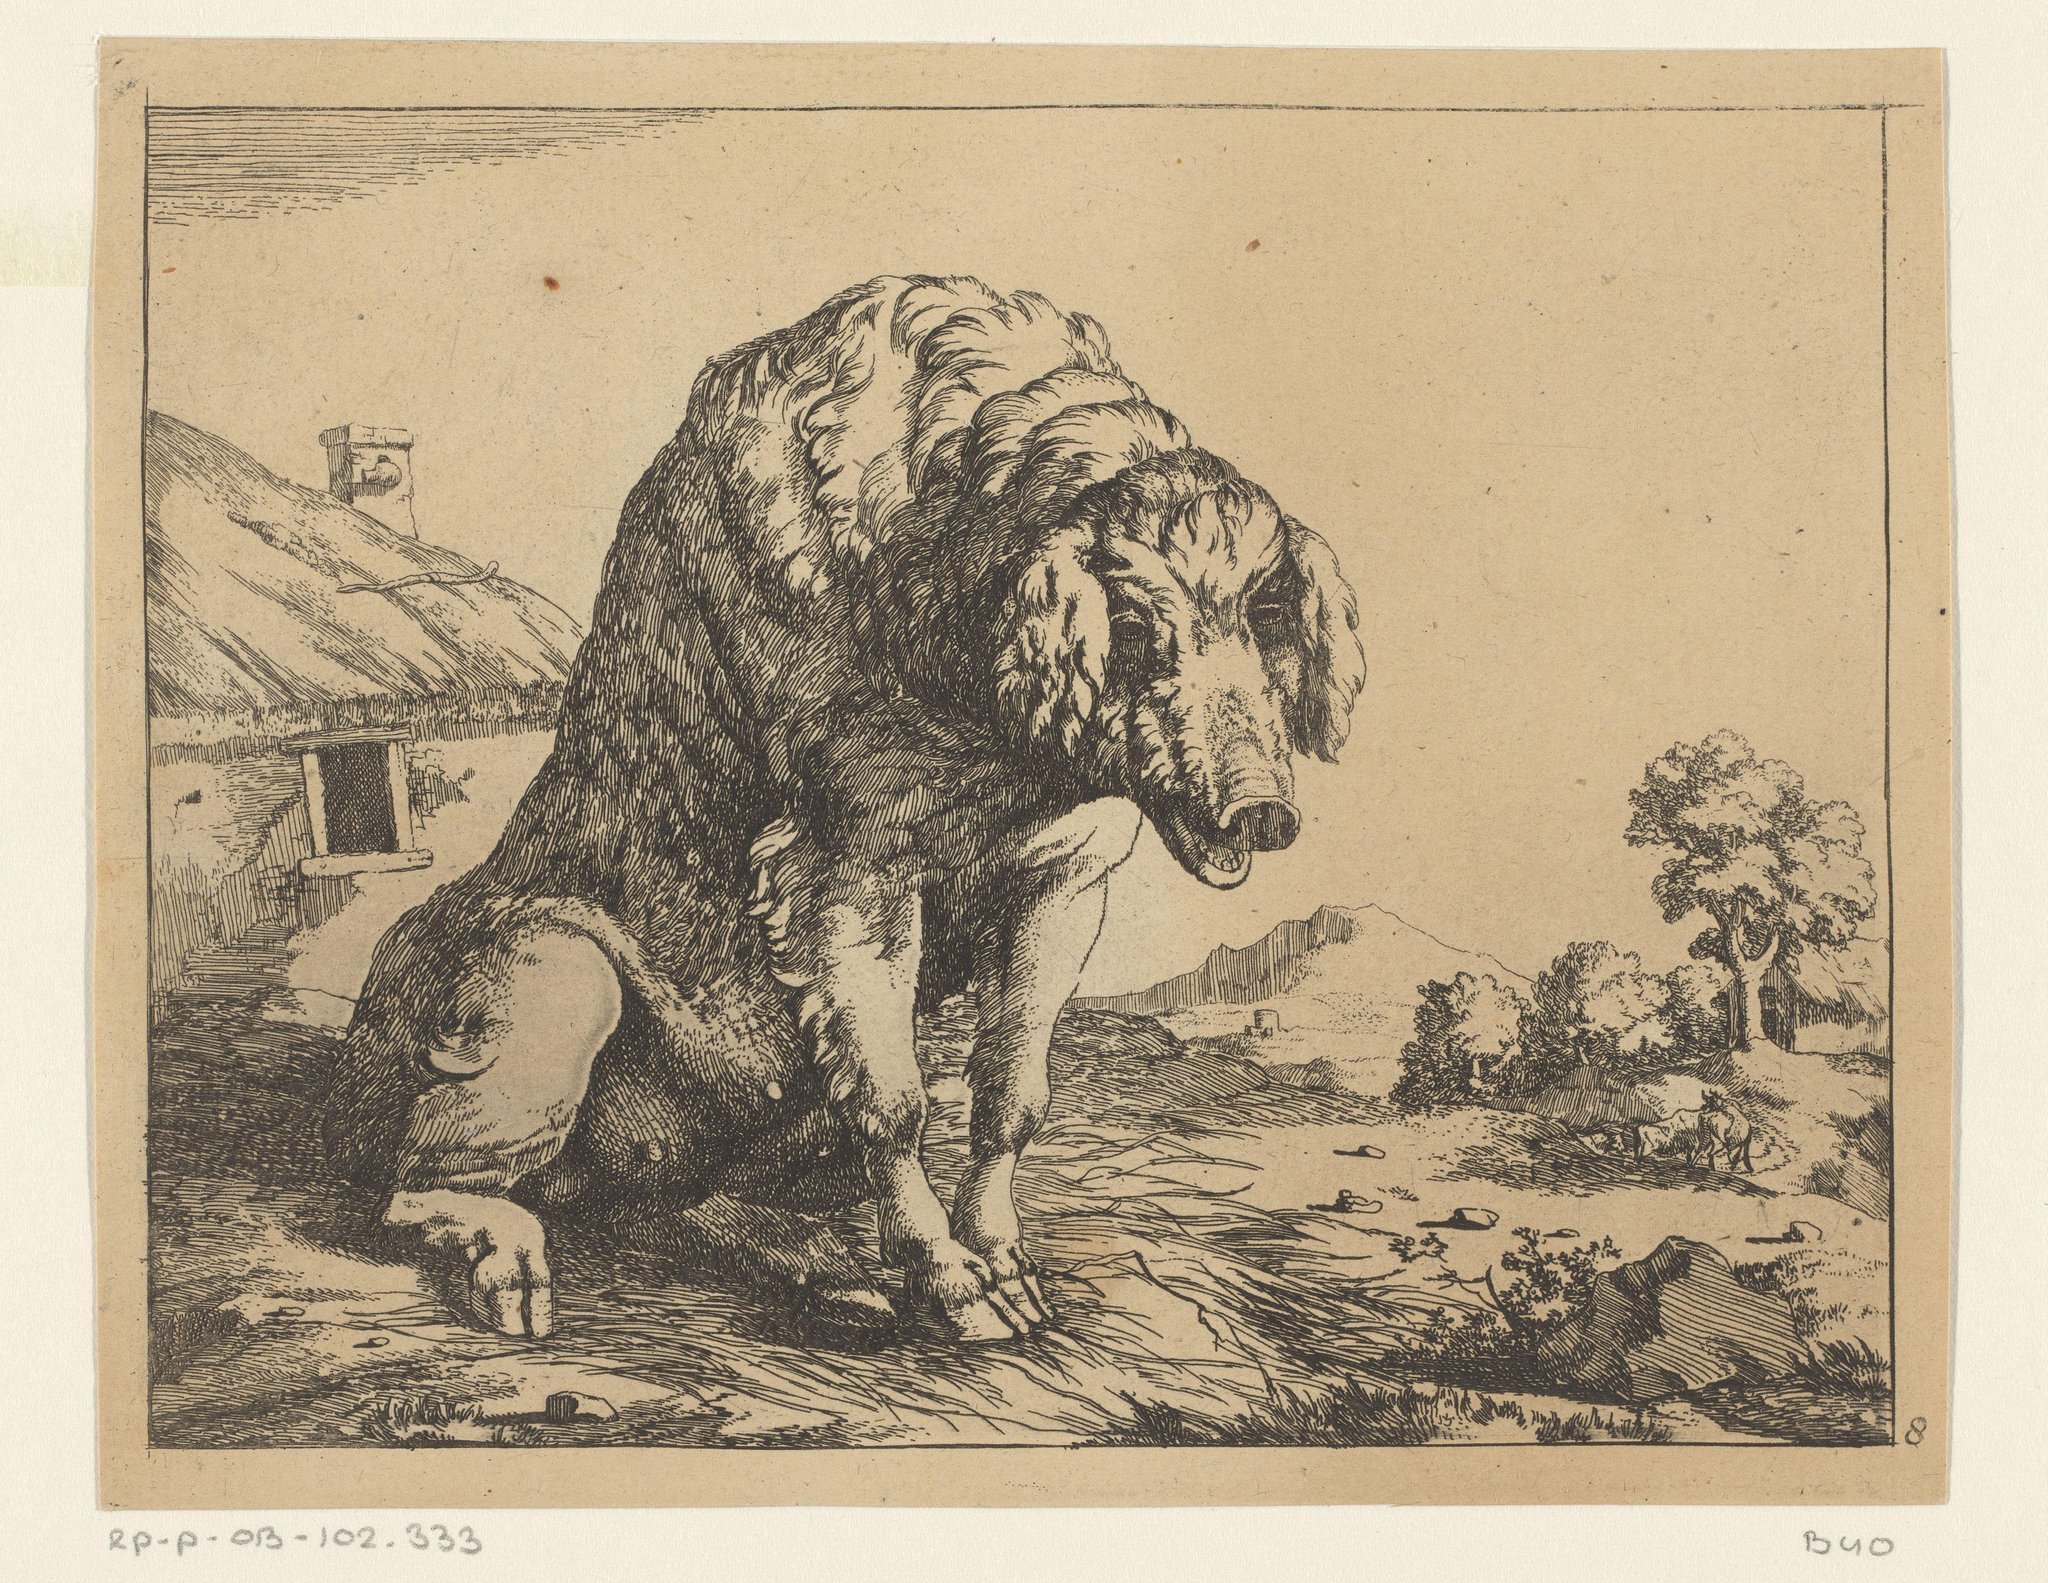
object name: print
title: Zeug zittend op achterpoten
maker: marcus de bye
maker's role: print maker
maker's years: 1639-1688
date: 1657-1677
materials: paper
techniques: etching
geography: the hague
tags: pig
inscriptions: collector's mark: Lugt 2228